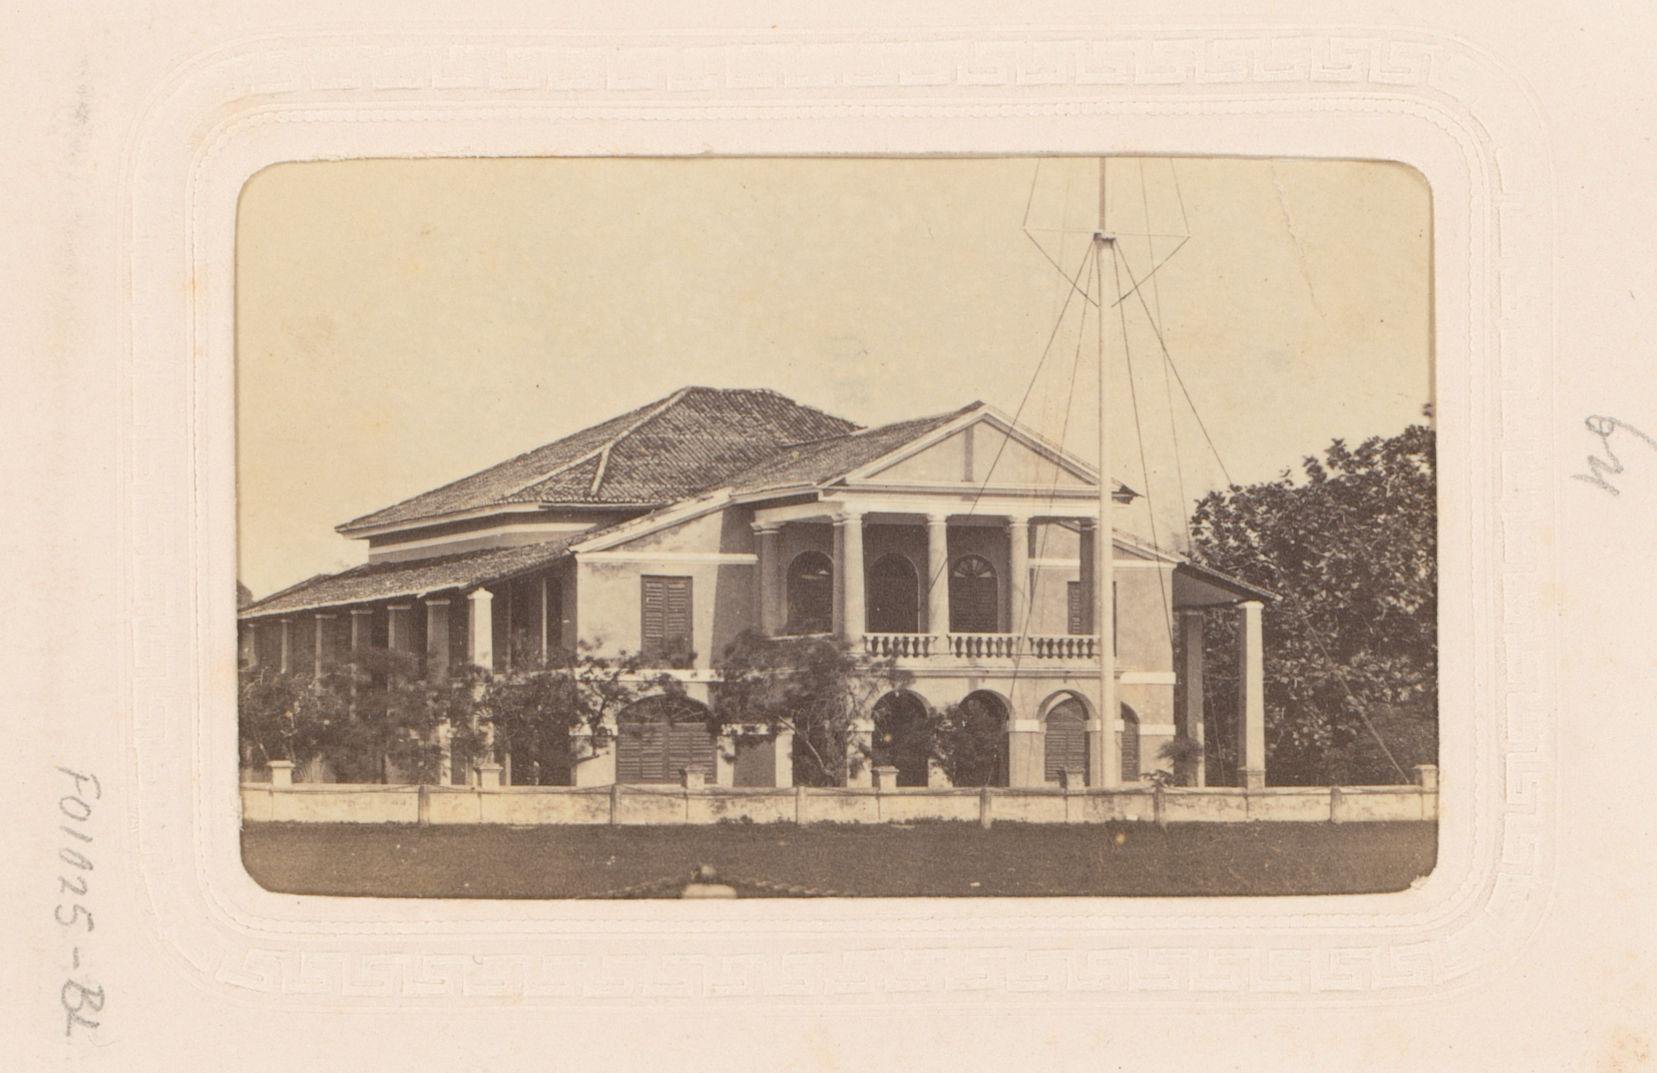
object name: carte de visite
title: Gezicht op een tempel van de vrijmetselarij te Singapore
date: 1867-1880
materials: cardboard, photographic support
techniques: albumen print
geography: singapore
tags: temple, shire ~ freemansonry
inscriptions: annotation: ‘Masonic Lodge [Zetland in the Cast] Singapore’, number: ‘64’